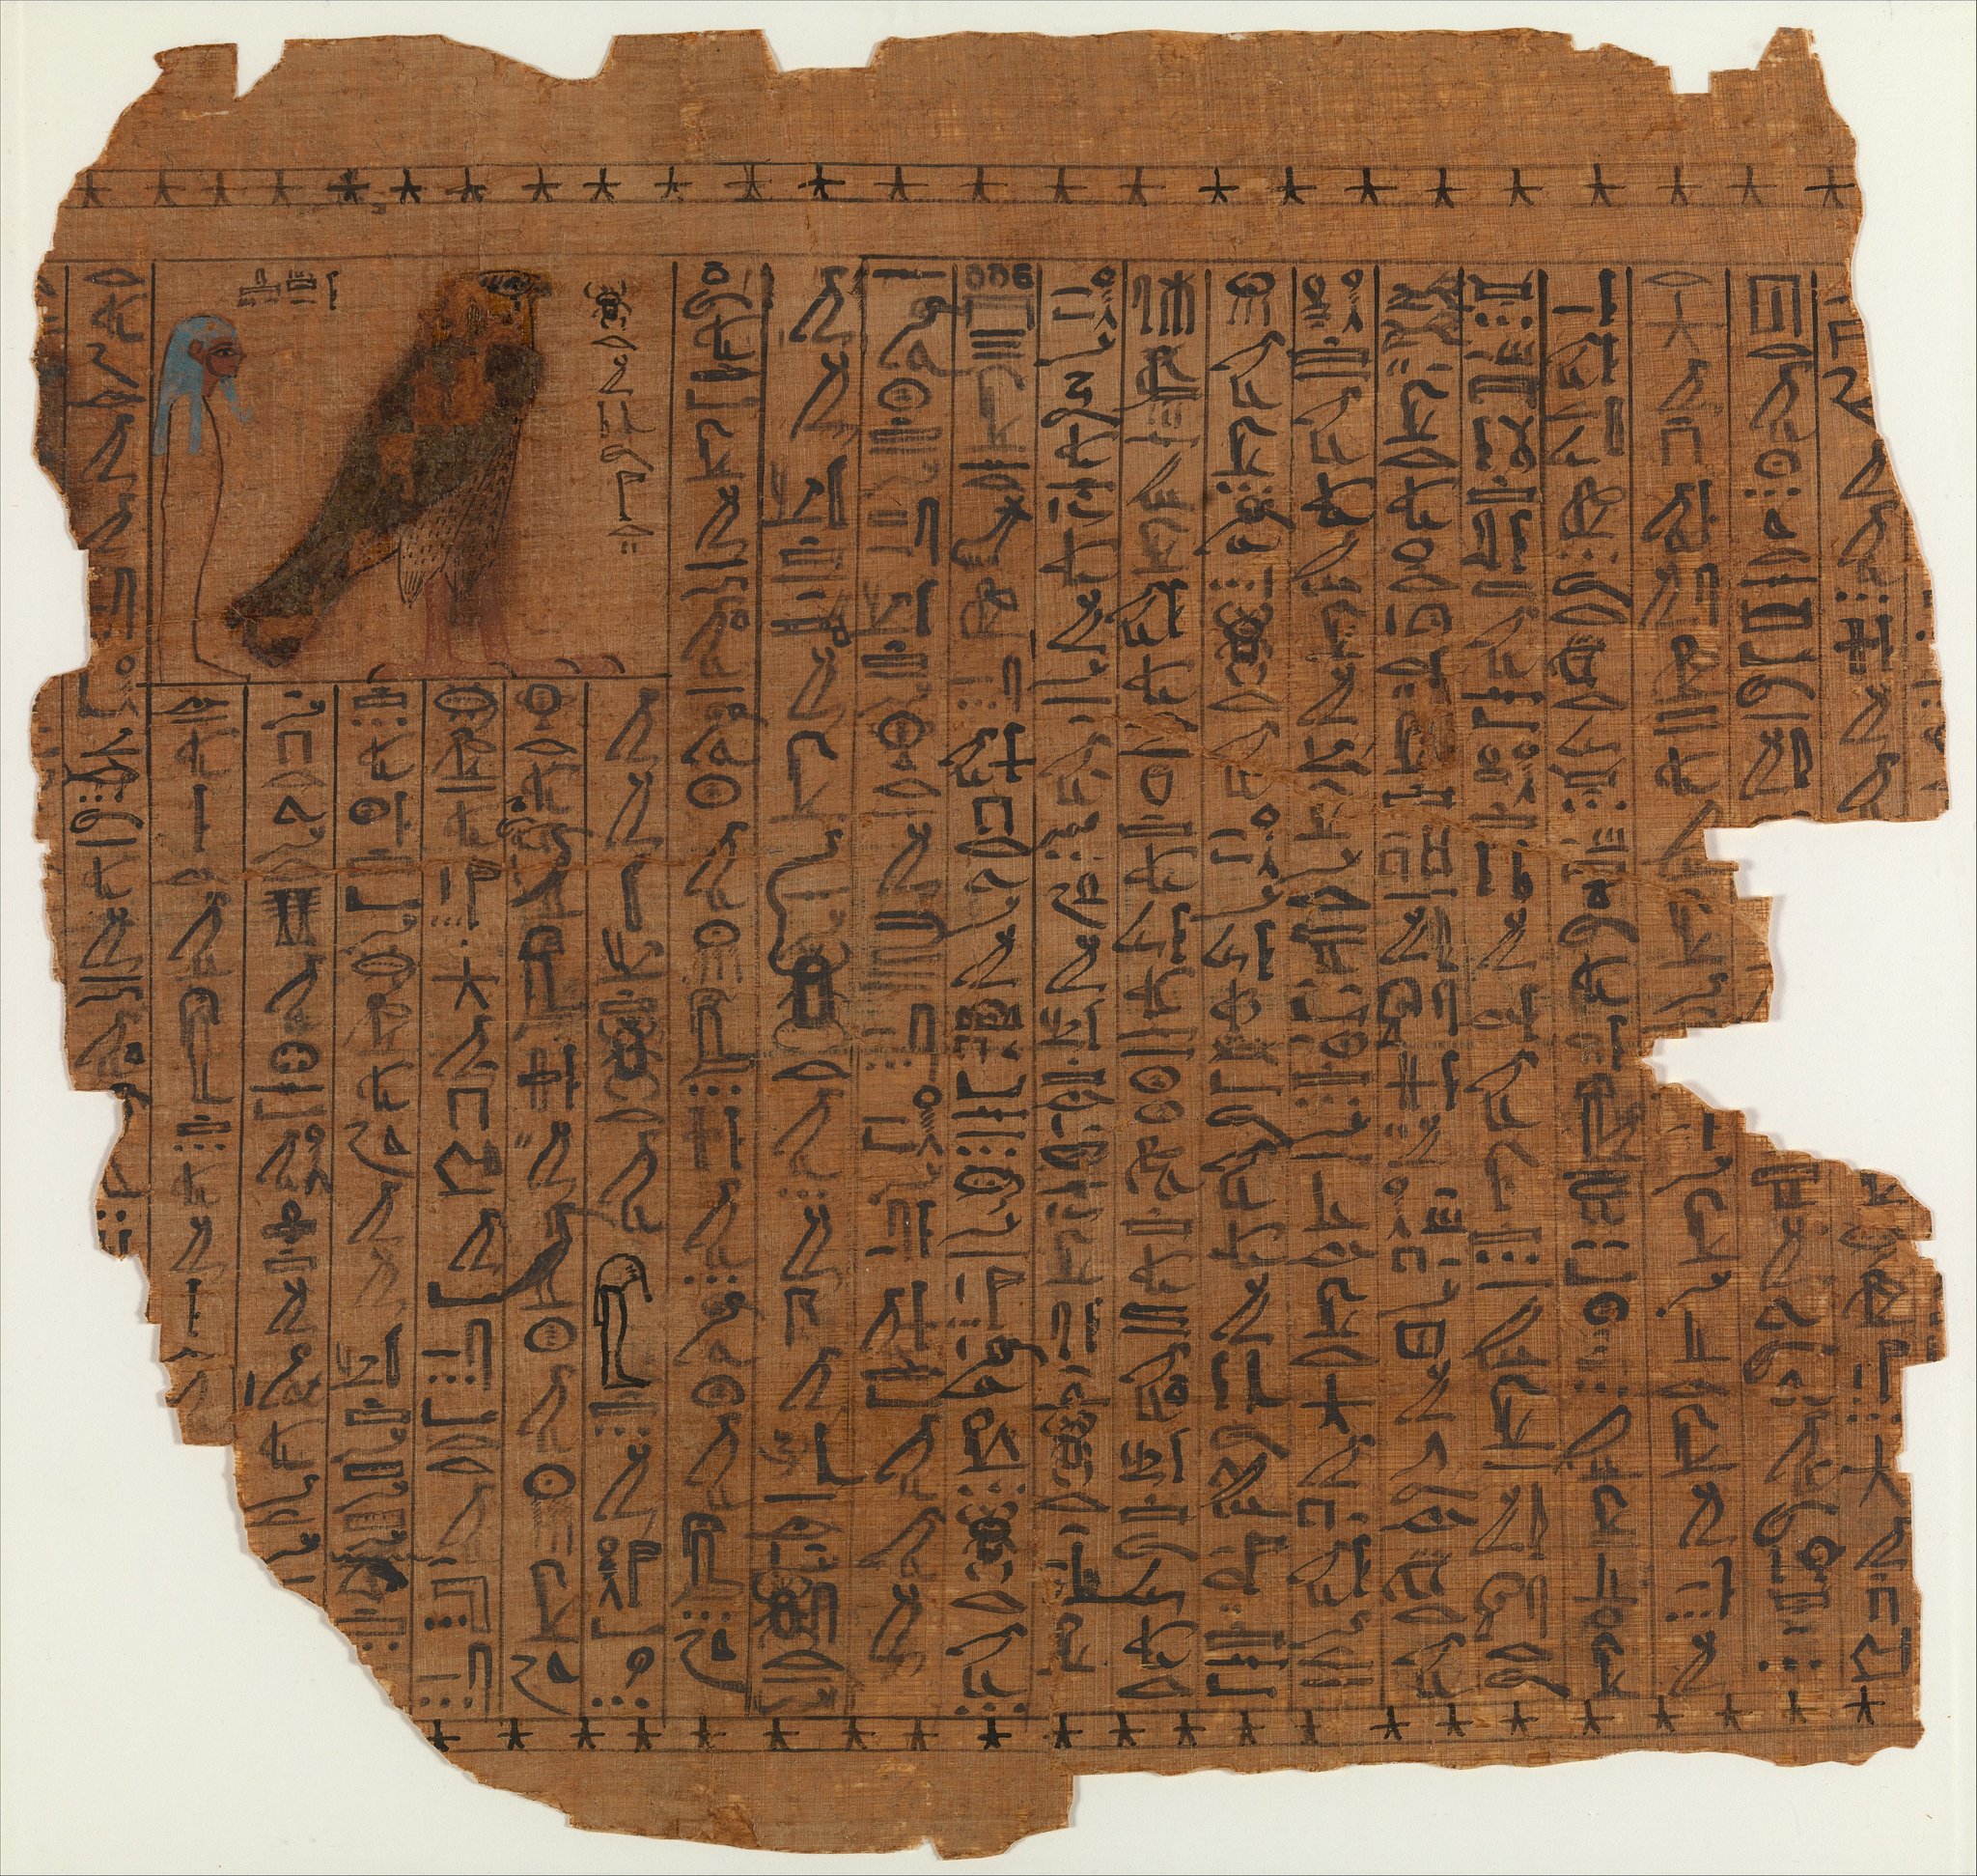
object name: papyrus, book of the dead, amenhotep, tt a 7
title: Sheet from the Papyrus of Amenhotep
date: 1427-1390 BCE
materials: ink, papyrus, pigment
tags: birds,hieroglyphs